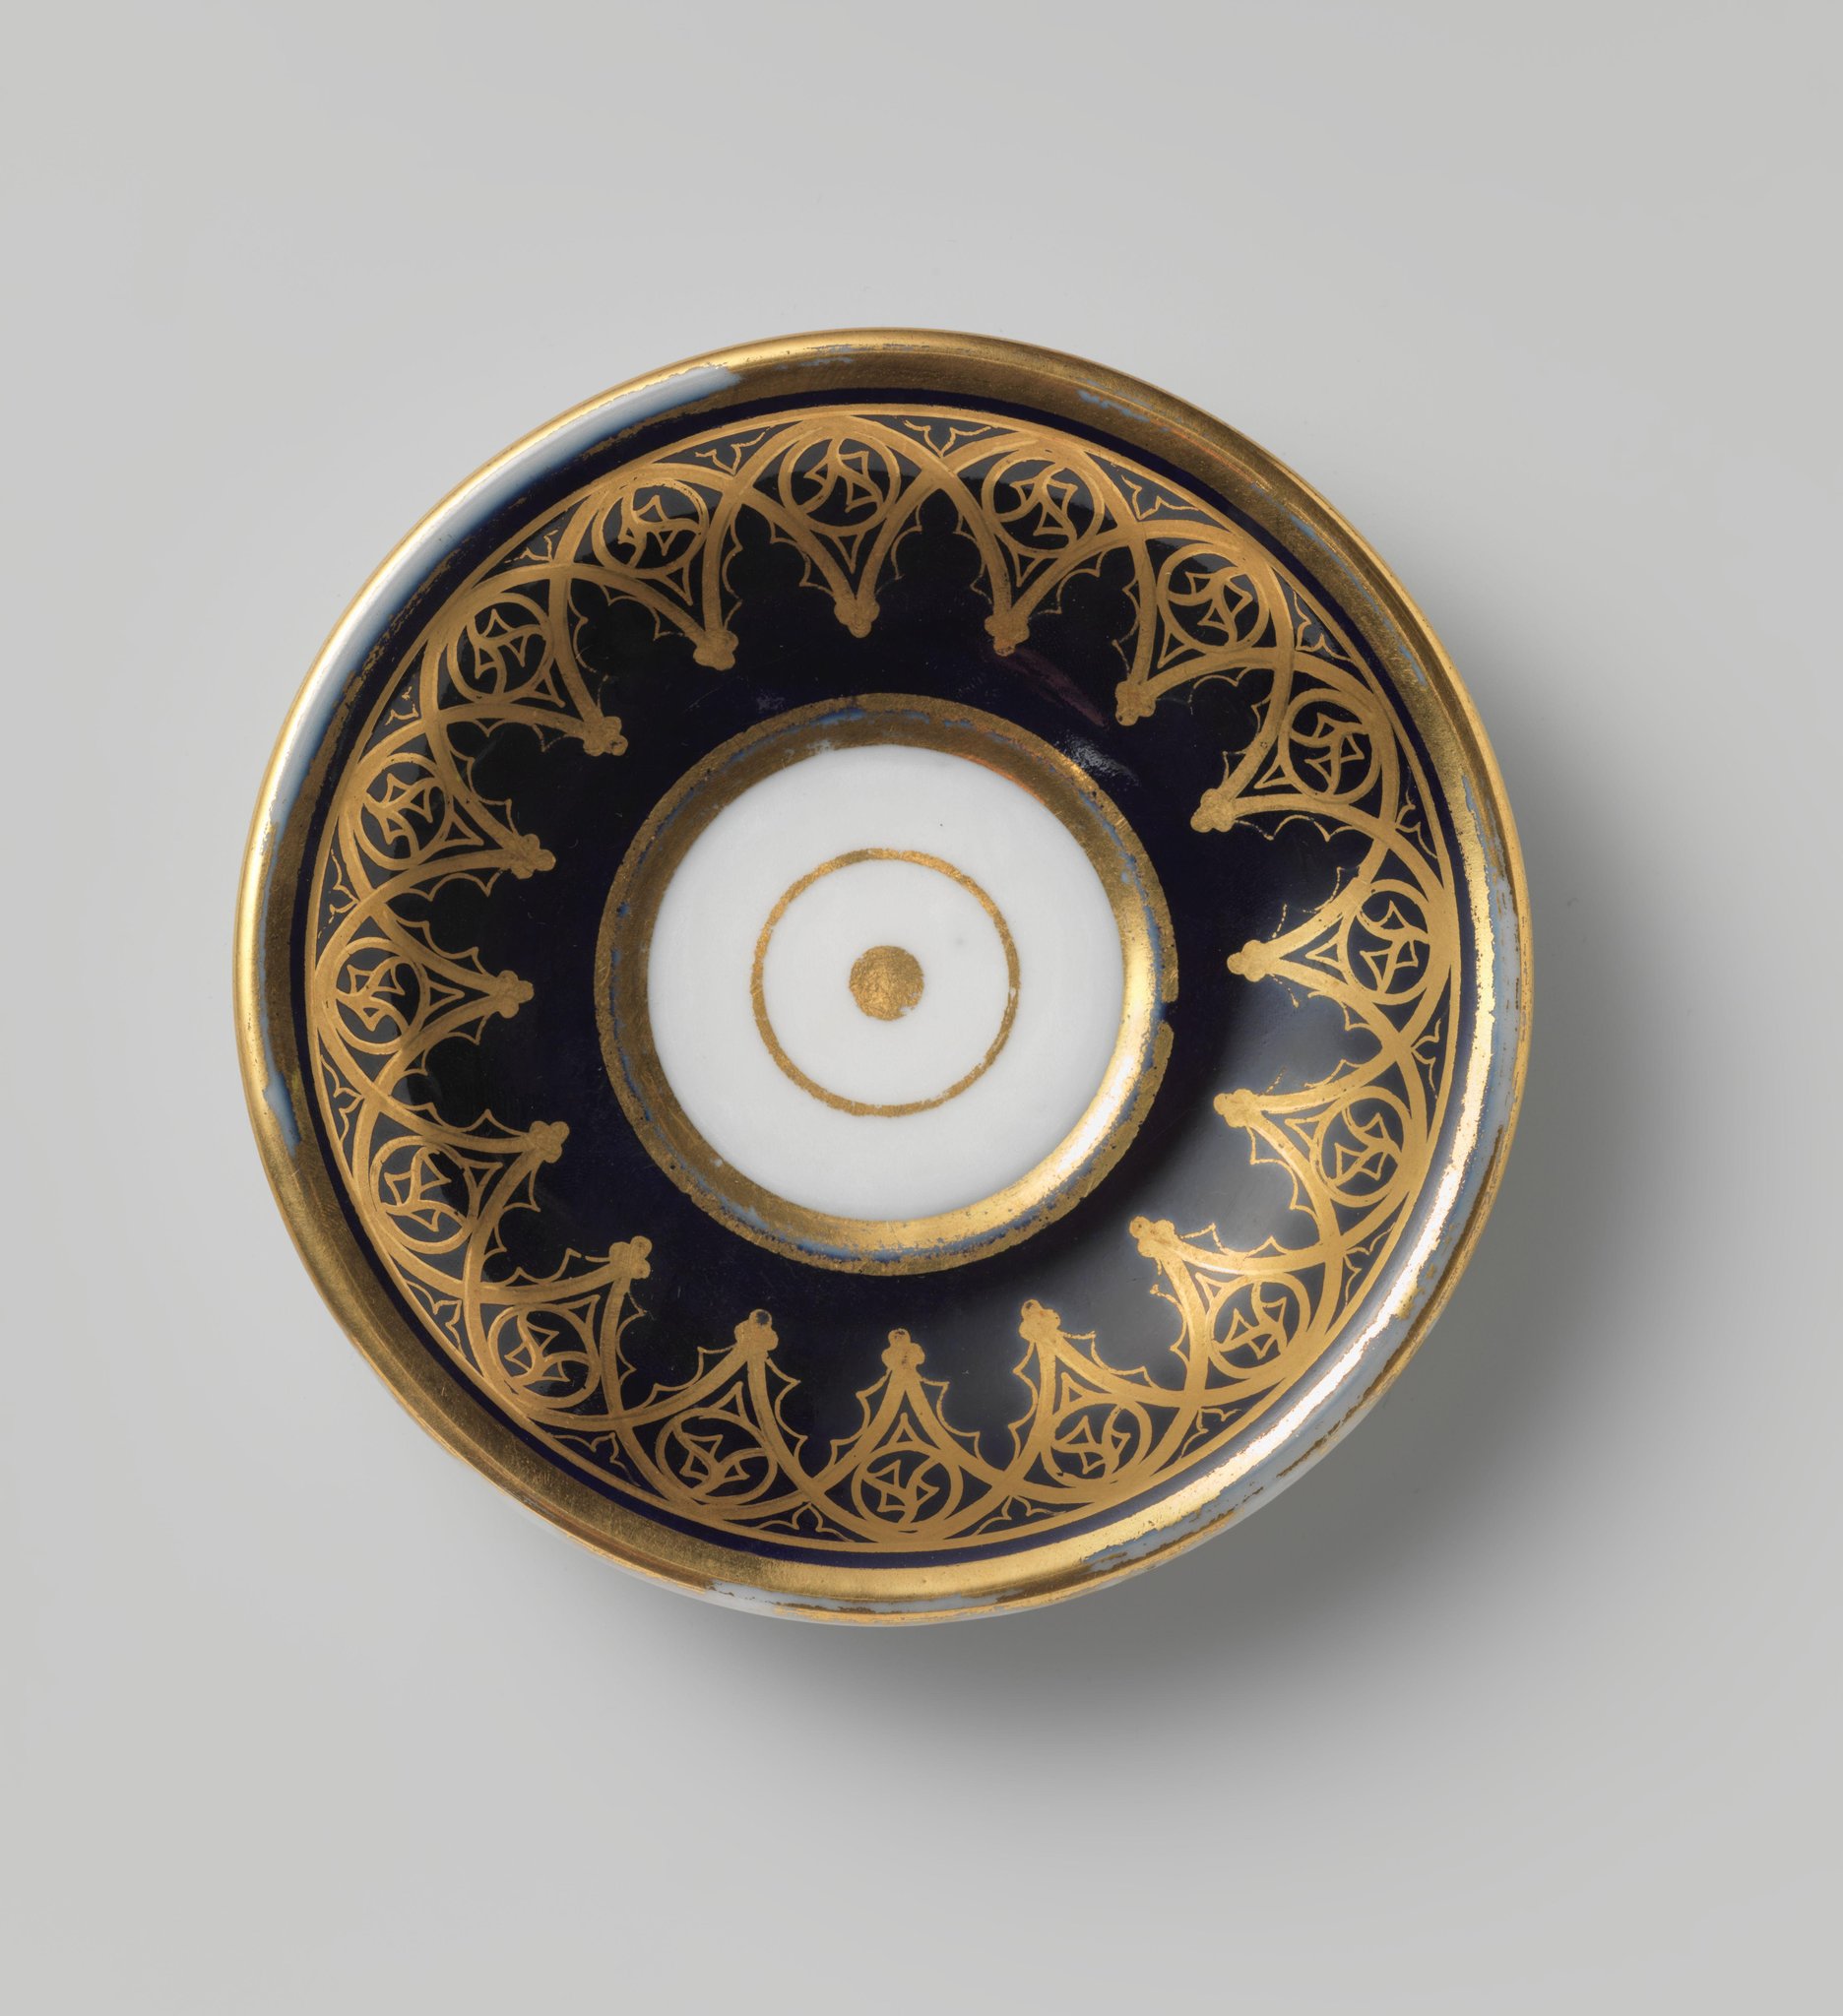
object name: service set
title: Saucer with a gothic arcade decoration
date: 1800-1899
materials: cobalt, glaze, gold, paint, porcelain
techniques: firing, forming, gilding, turning, vitrification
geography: saint-yrieix-la-perche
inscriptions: mark: ‘vis’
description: Schotel van porselein, deel van servies, beschilderd in goud op een koningsblauw fond met een arcademotief met gotische traceringen. Buiten dit decor en voor een groot deel aan de binnenzijde verguld. Gemerkt met een groen visje. Opmerking: zie voor merken ook het algemeen record.